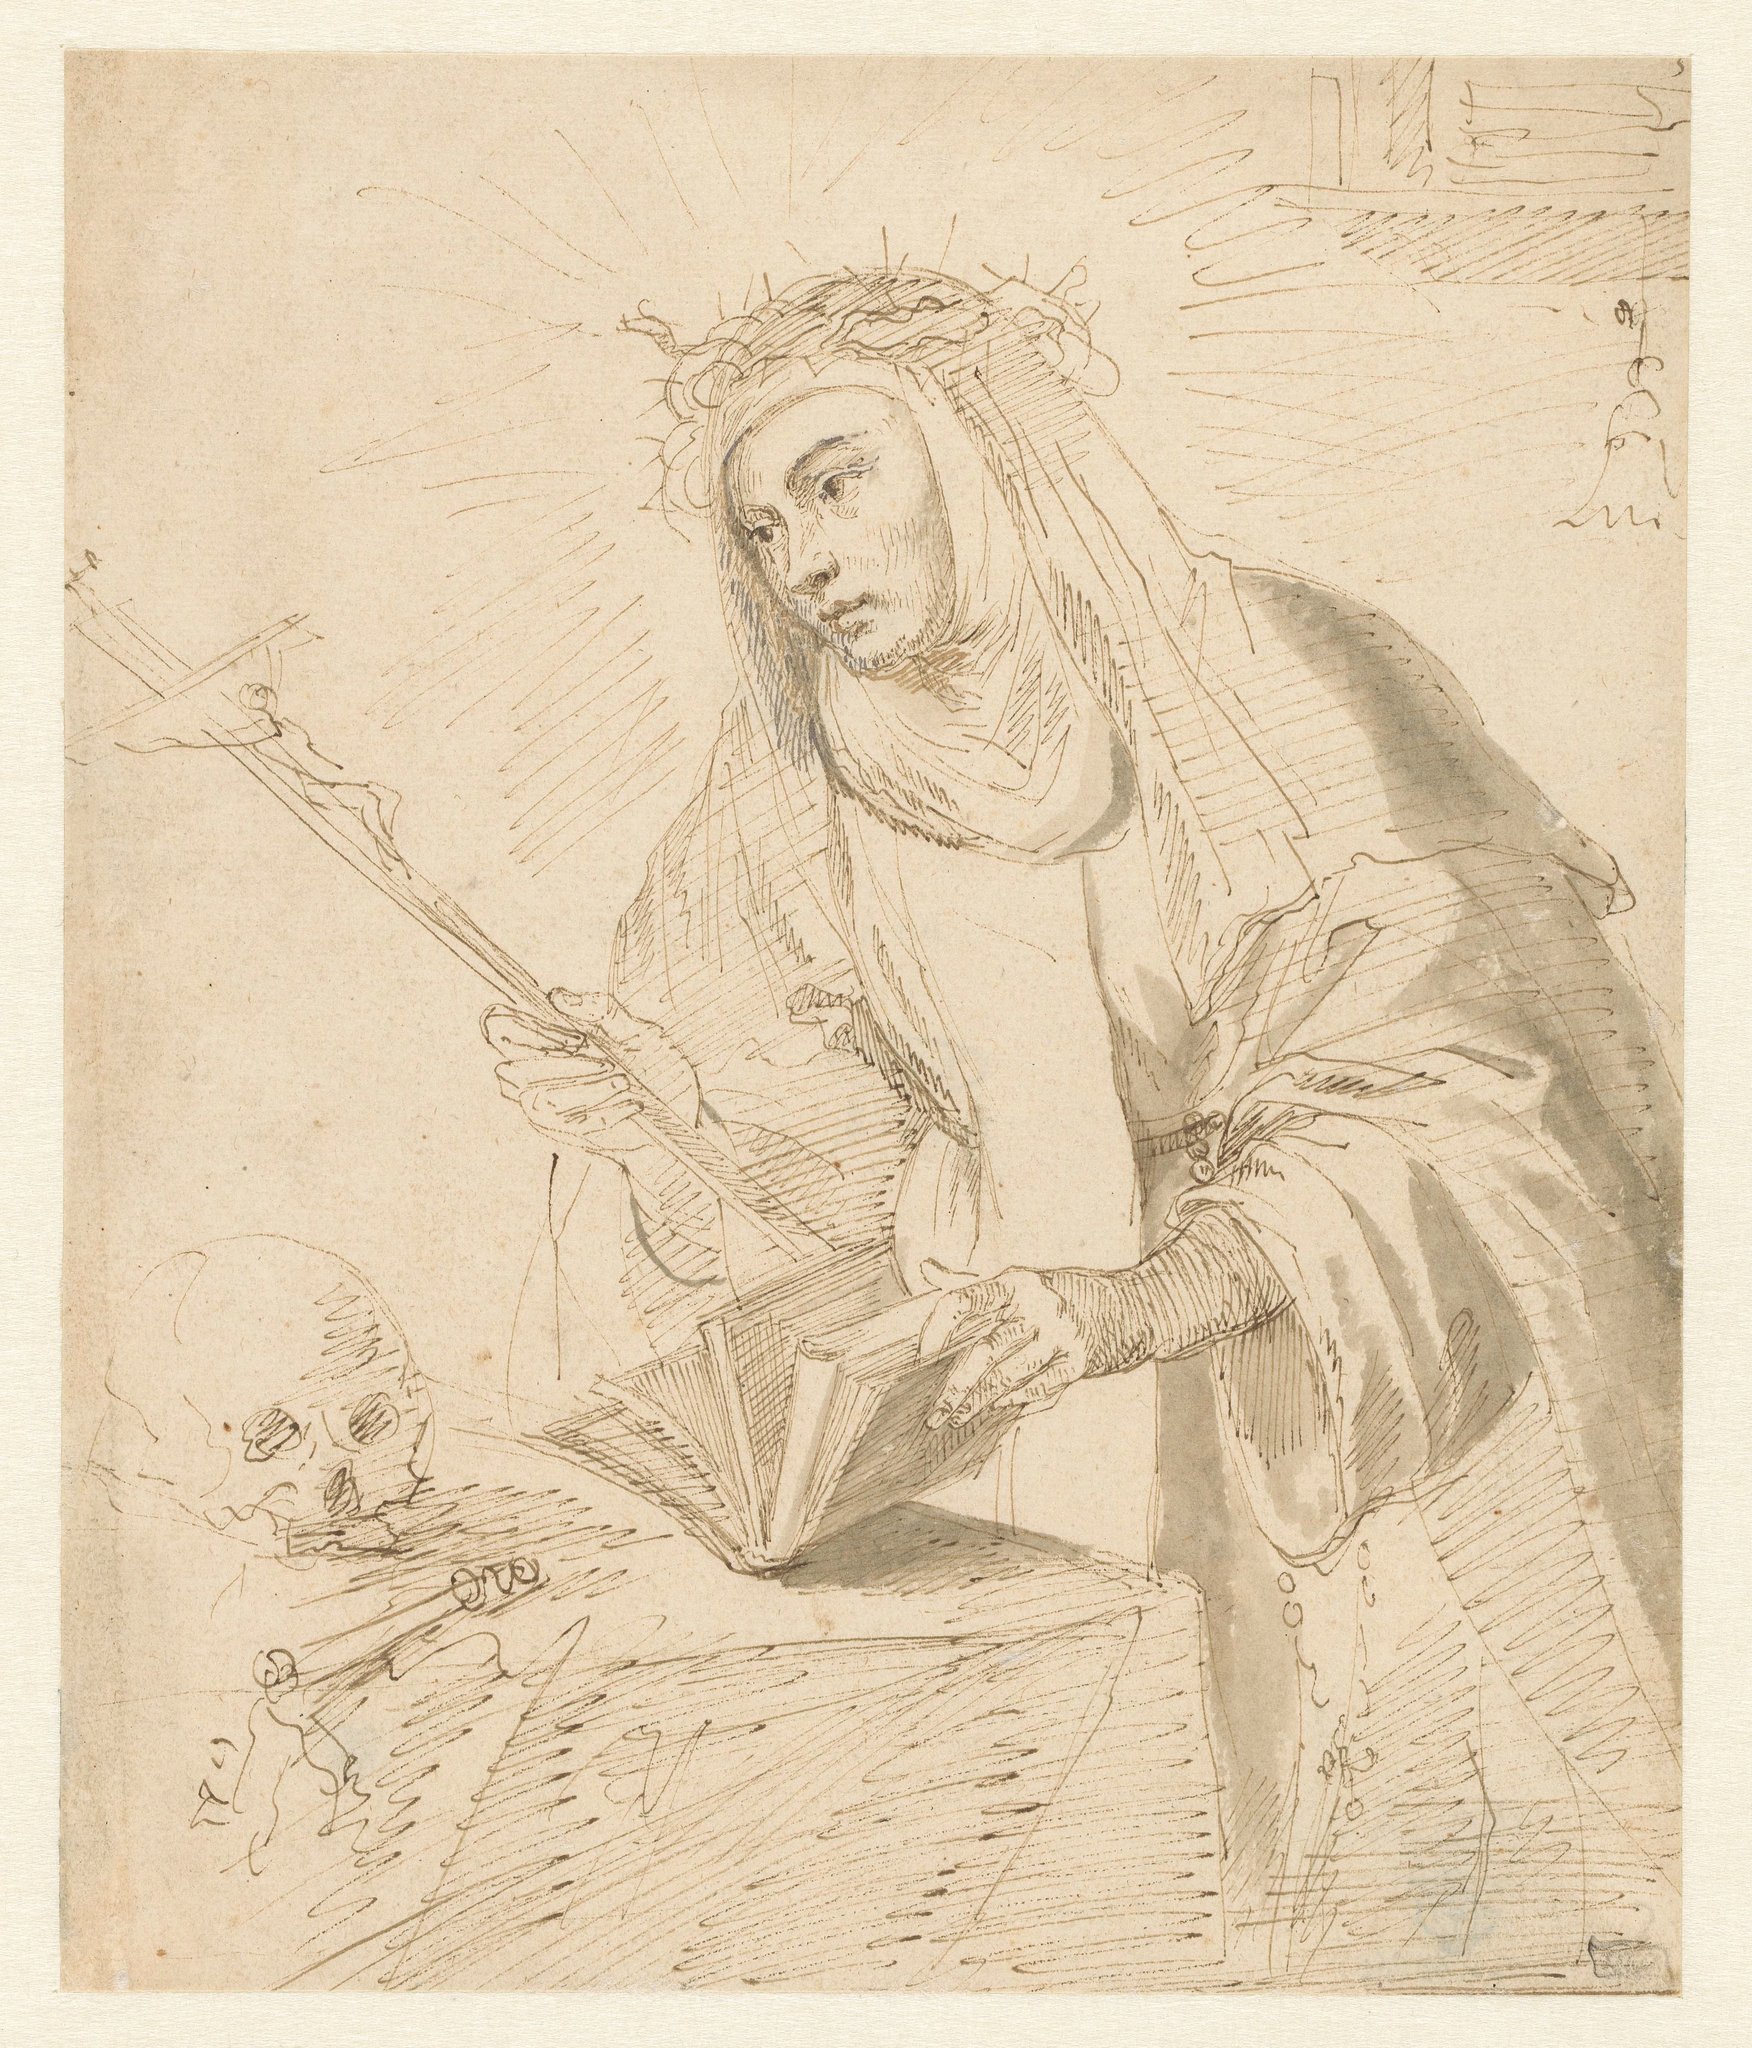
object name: drawing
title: H. Catharina in contemplatie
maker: matthys van den bergh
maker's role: draughtsman, print maker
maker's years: 1617-1687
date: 1627-1687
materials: ink, paper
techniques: brush, pen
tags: the virgin and dominican tertiary, catherine of siena; possible attributes: book, cross, crown of thorns, crucifix, demon under foot, heart (with cross), lily, plague-stricken, ring, rosary, stigmata